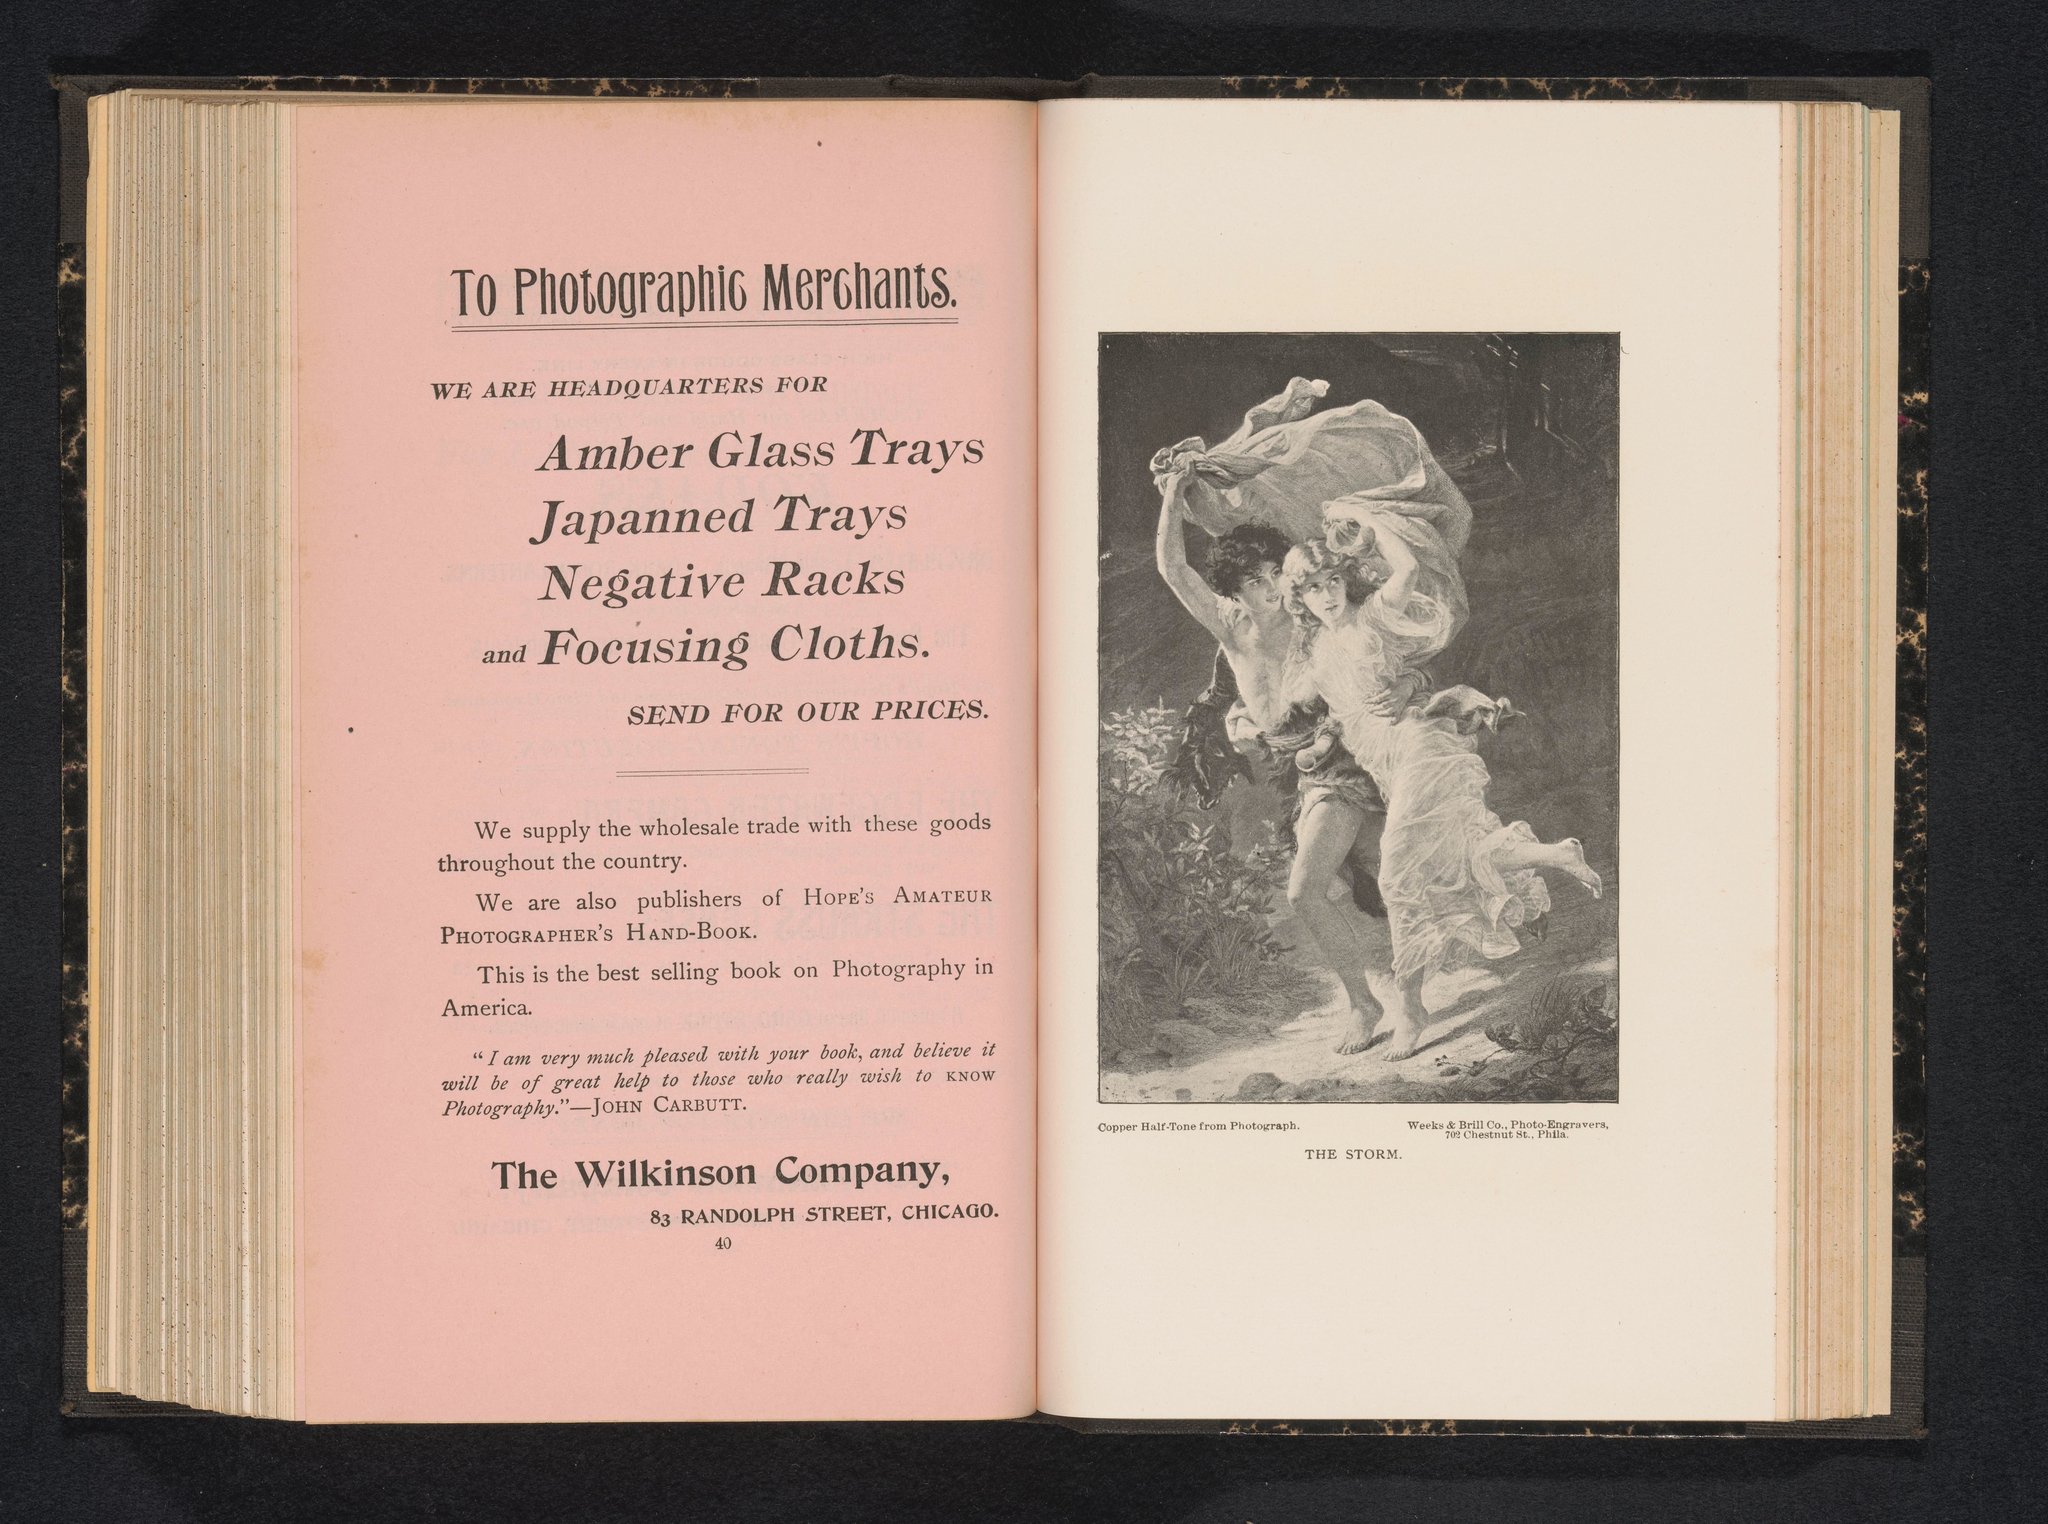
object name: page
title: The Storm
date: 1887-1907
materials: paper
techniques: autotype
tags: couple of lovers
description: Prent tegenover pagina 40 van de advertenties.